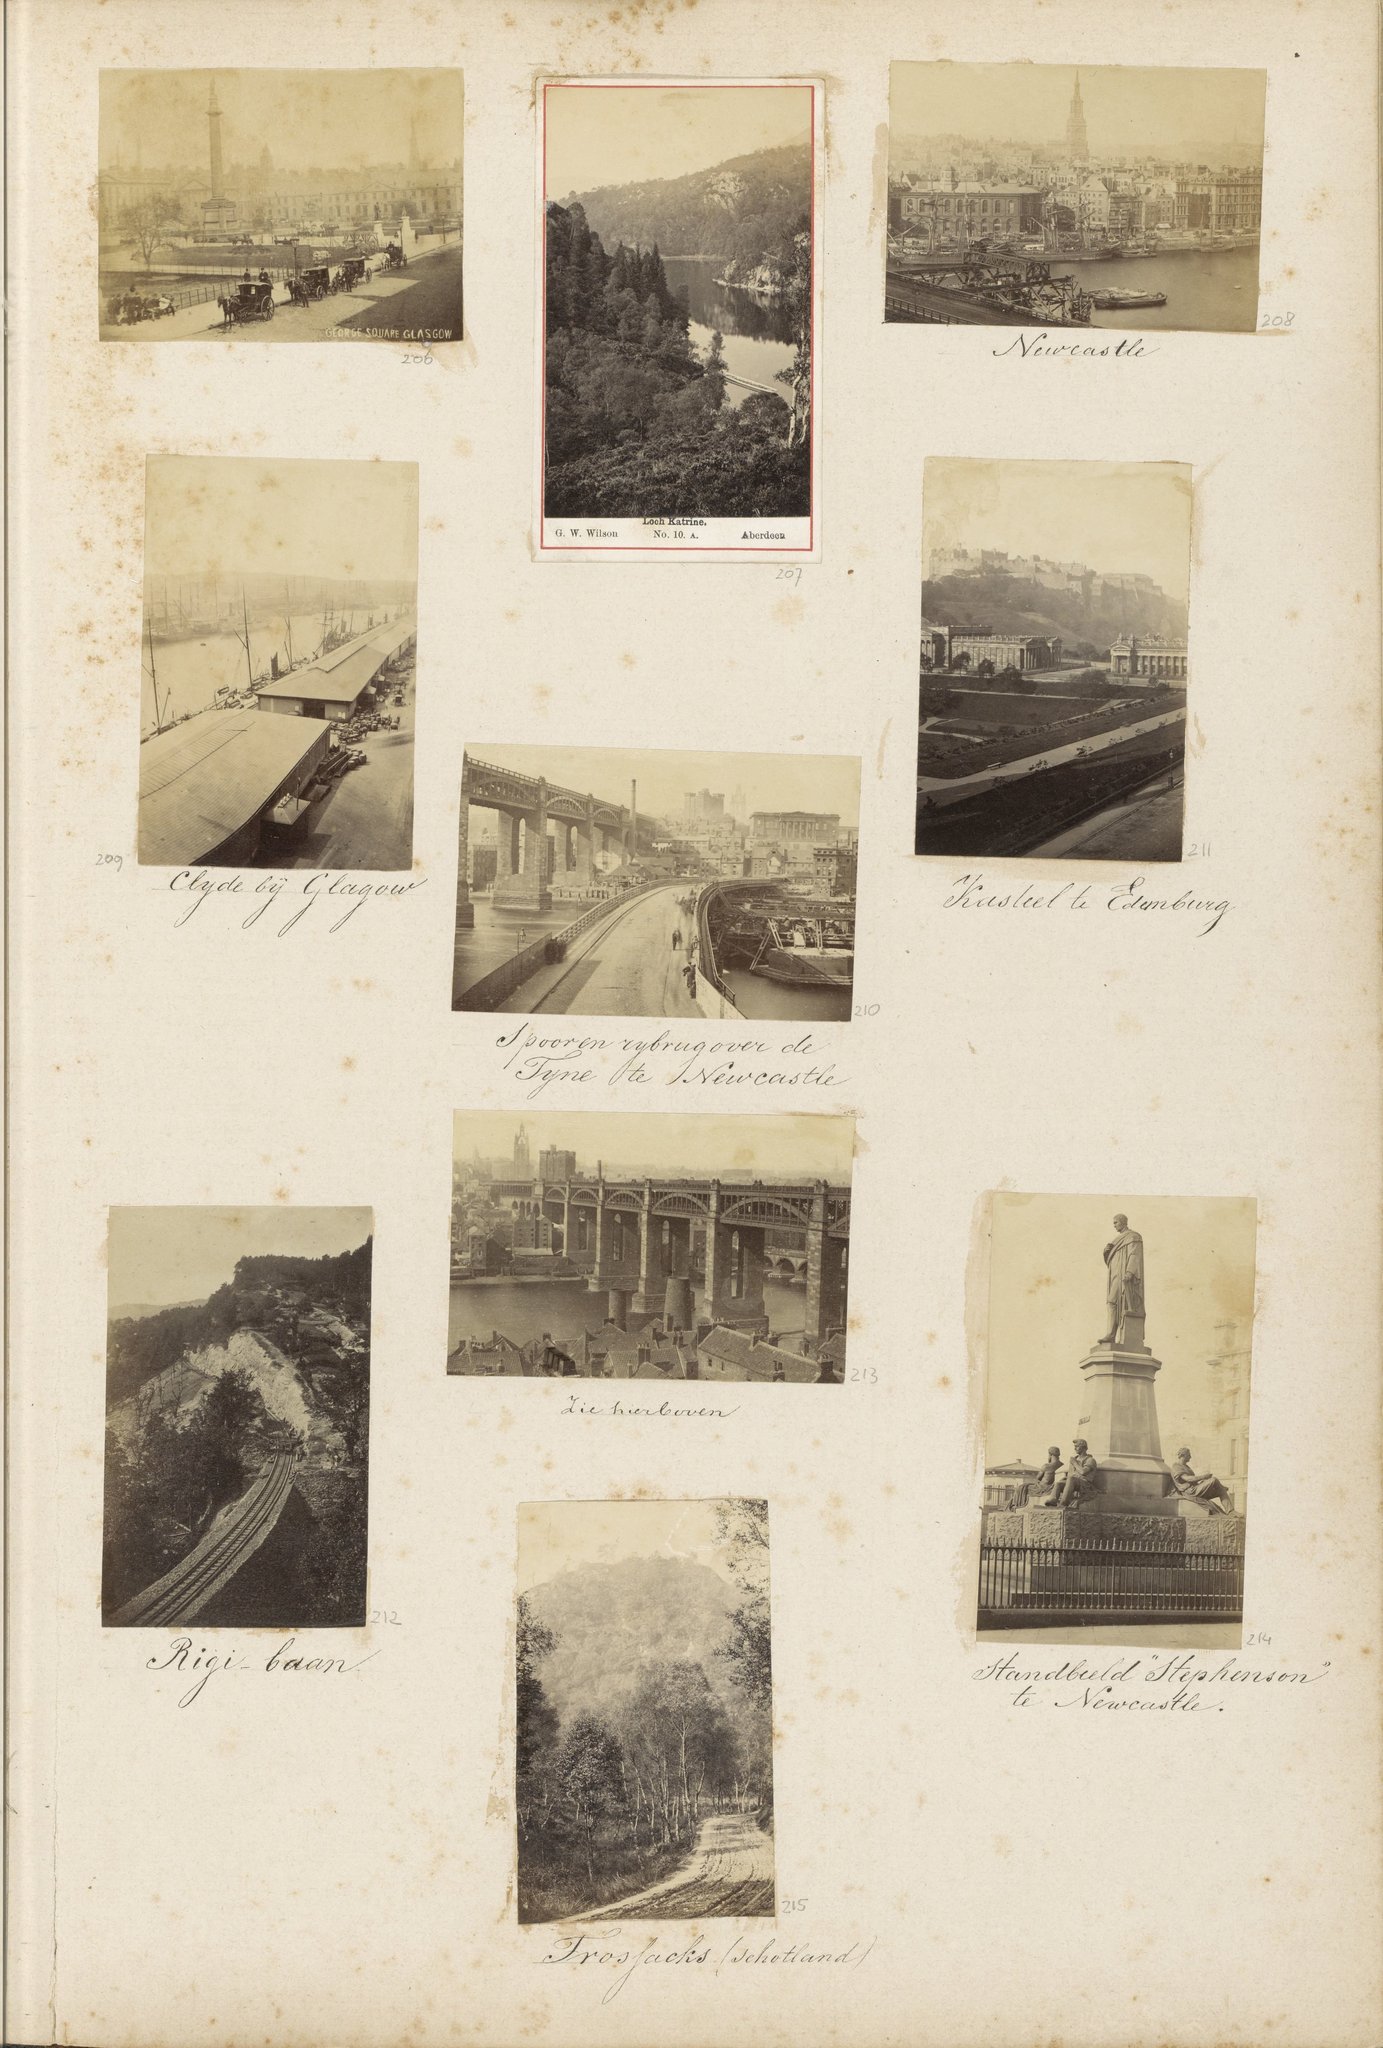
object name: photograph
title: Stephenson Memorial in Newcastle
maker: Anonymous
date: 1870-1880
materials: paper, photographic support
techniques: albumen print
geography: newcastle upon tyne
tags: monument, statue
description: Onderdeel van Fotoalbum van Robert Daniel Crommelin (1841-1907).